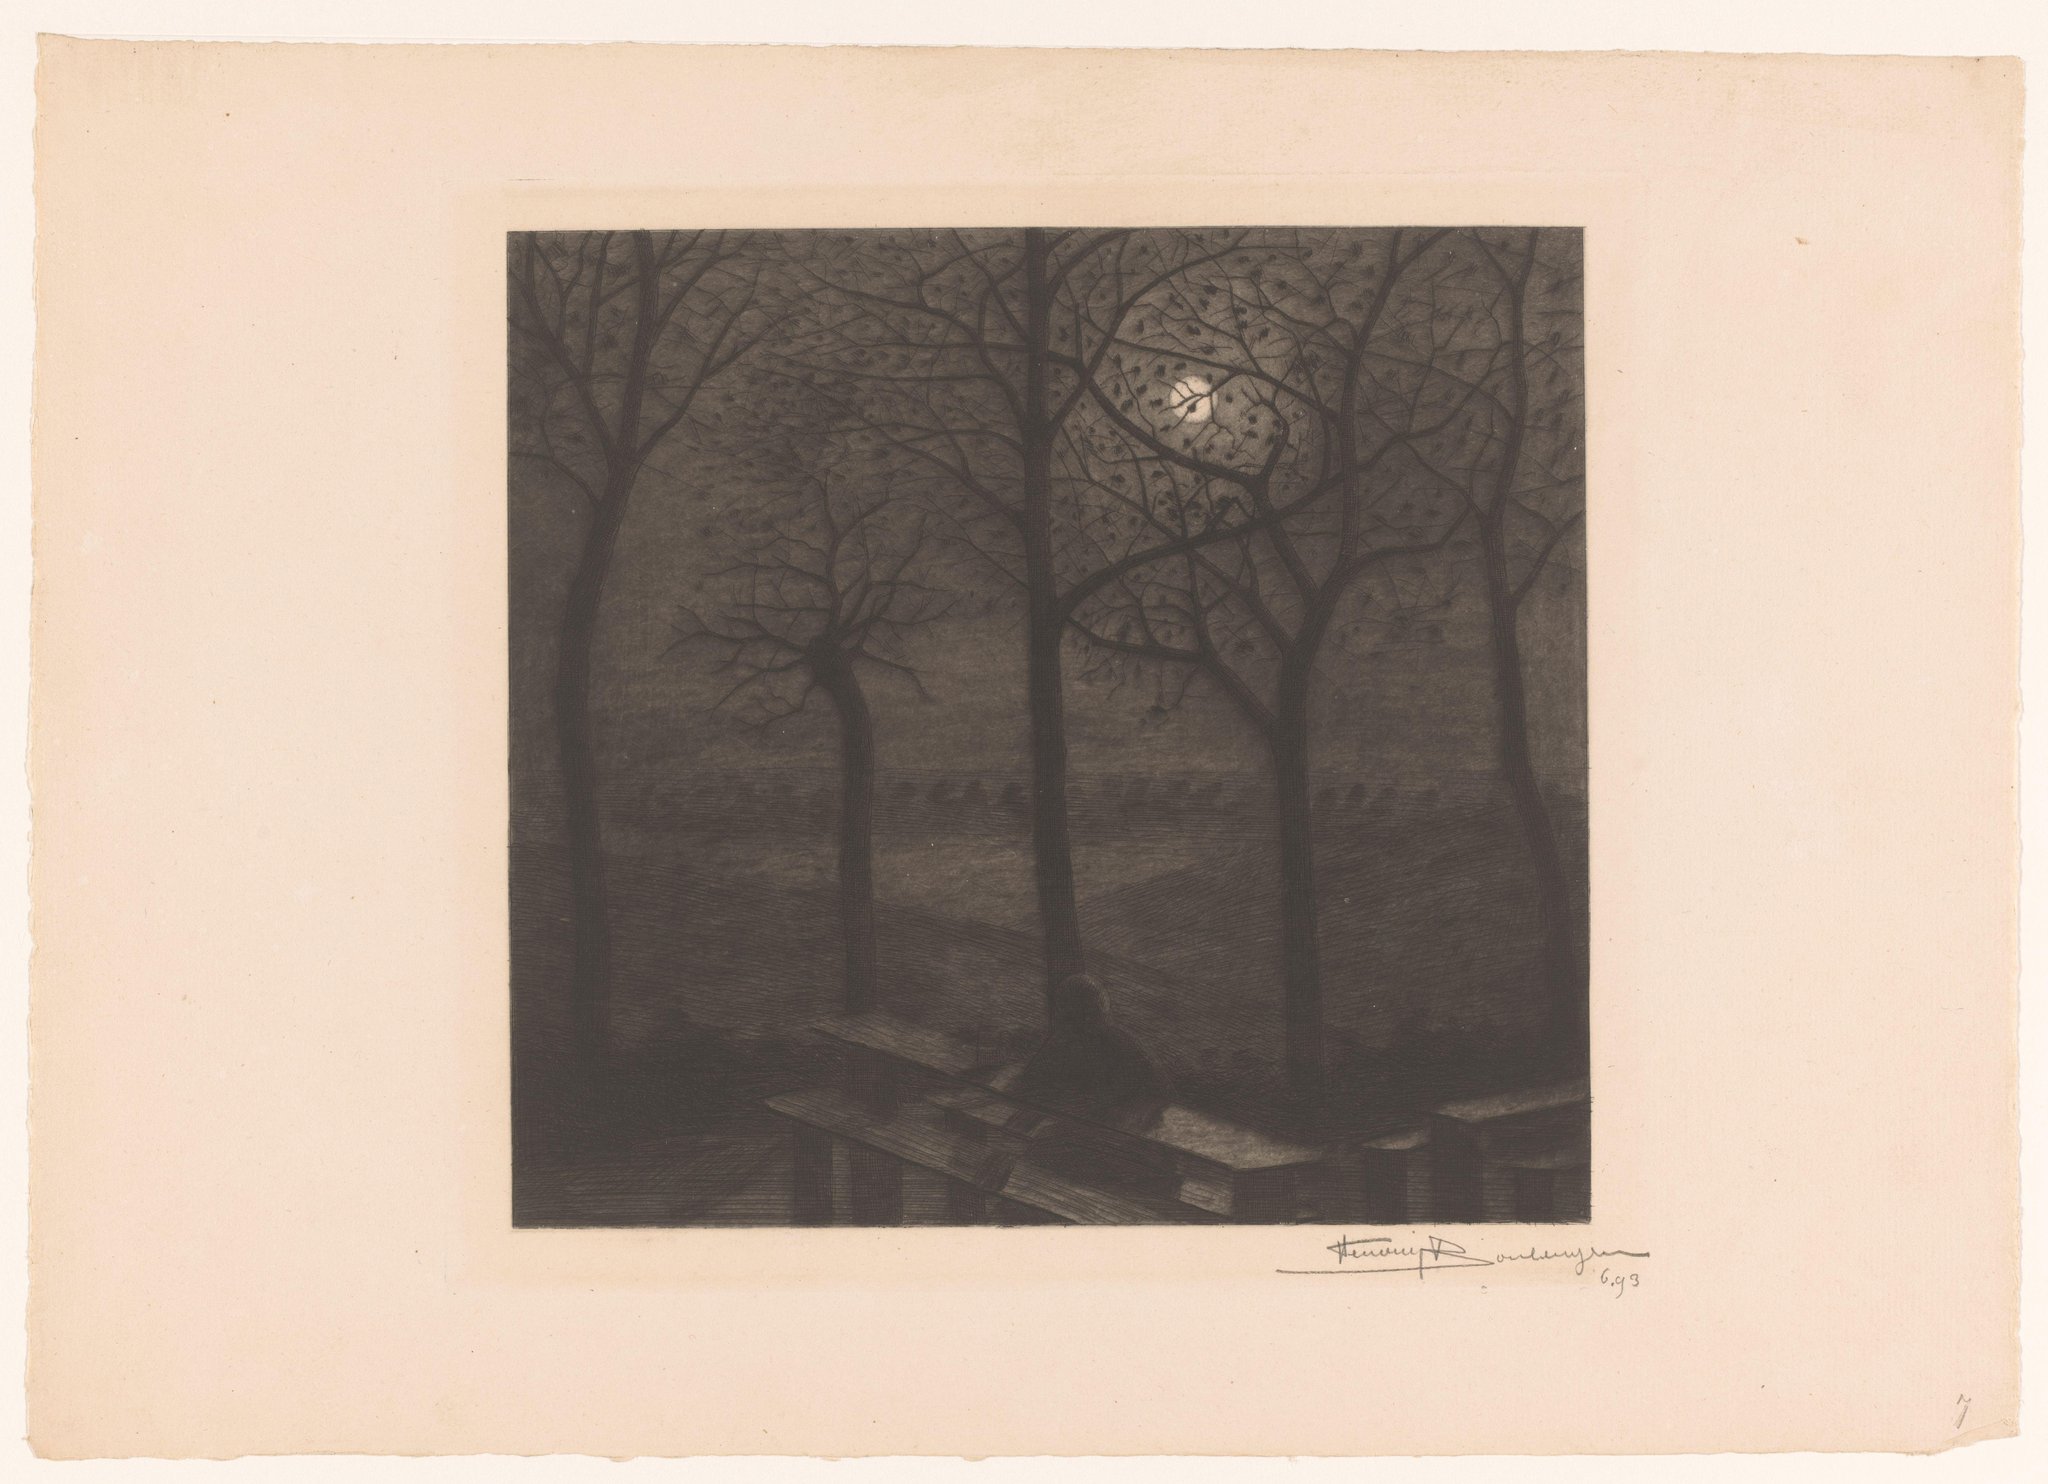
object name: print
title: Figuur aan een picknicktafel in een door de maan beschenen landschap met kale bomen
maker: herman boulenger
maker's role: draughtsman, print maker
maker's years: 1871-1913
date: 1806-1893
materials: paper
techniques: drypoint, etching, intaglio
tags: moonlight, resting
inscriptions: collector's mark: Lugt 2228